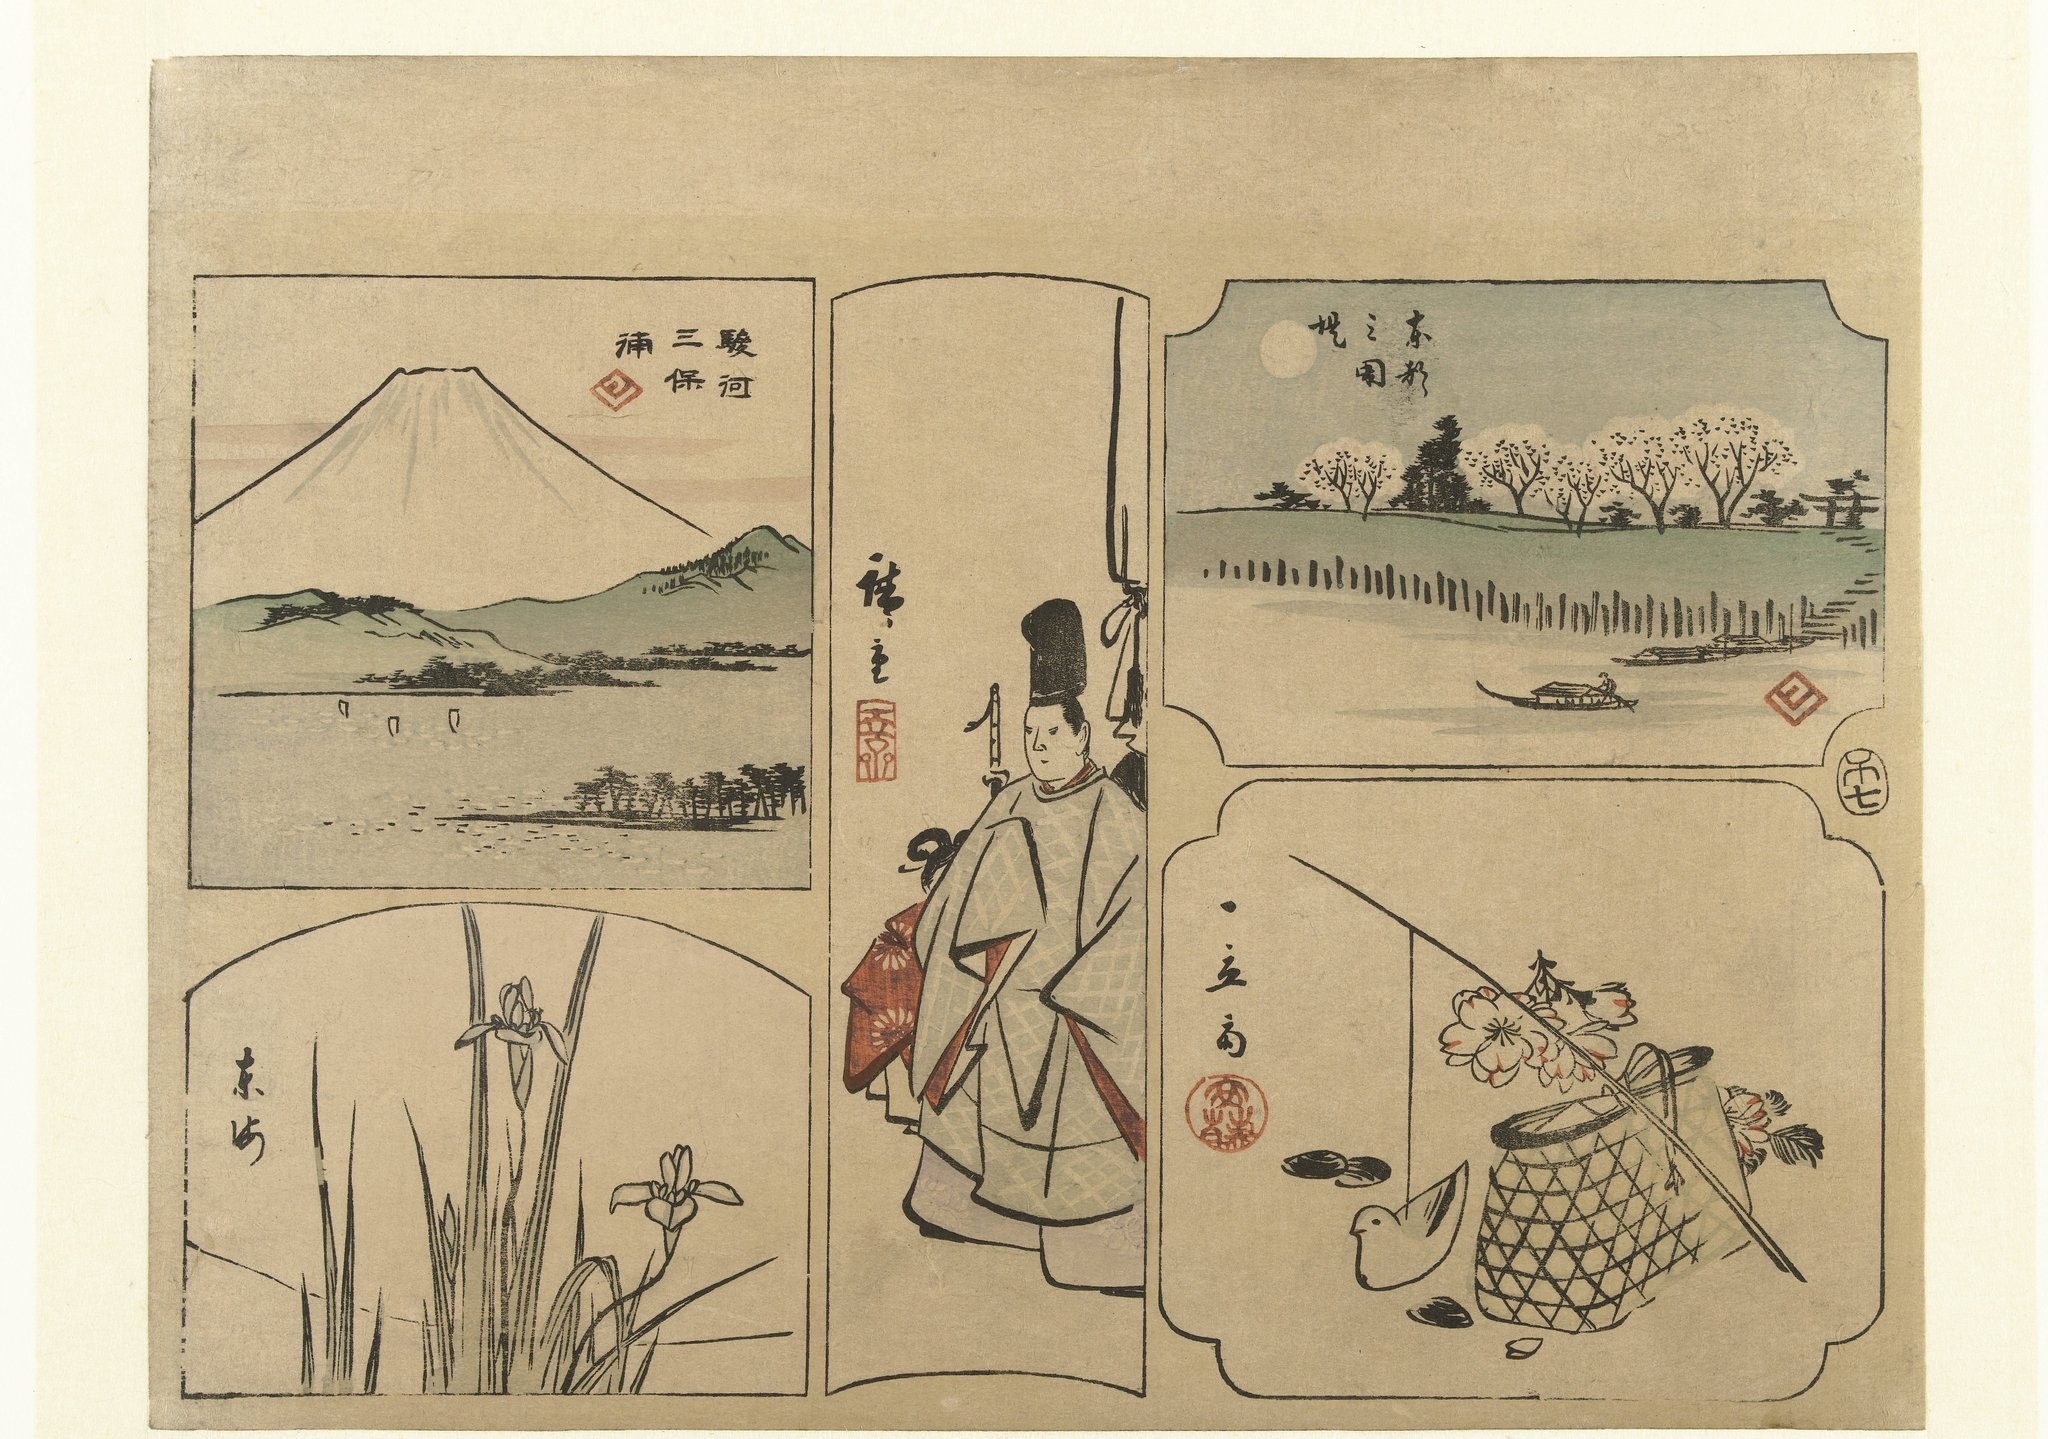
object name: print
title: Harimaze met Fuji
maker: utagawa hiroshige (i)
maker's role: draughtsman, print maker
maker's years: 1797-1858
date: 1858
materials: paper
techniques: woodcut, nishiki e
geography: tokyo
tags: plants; vegetation, standing figure, landscapes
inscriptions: date